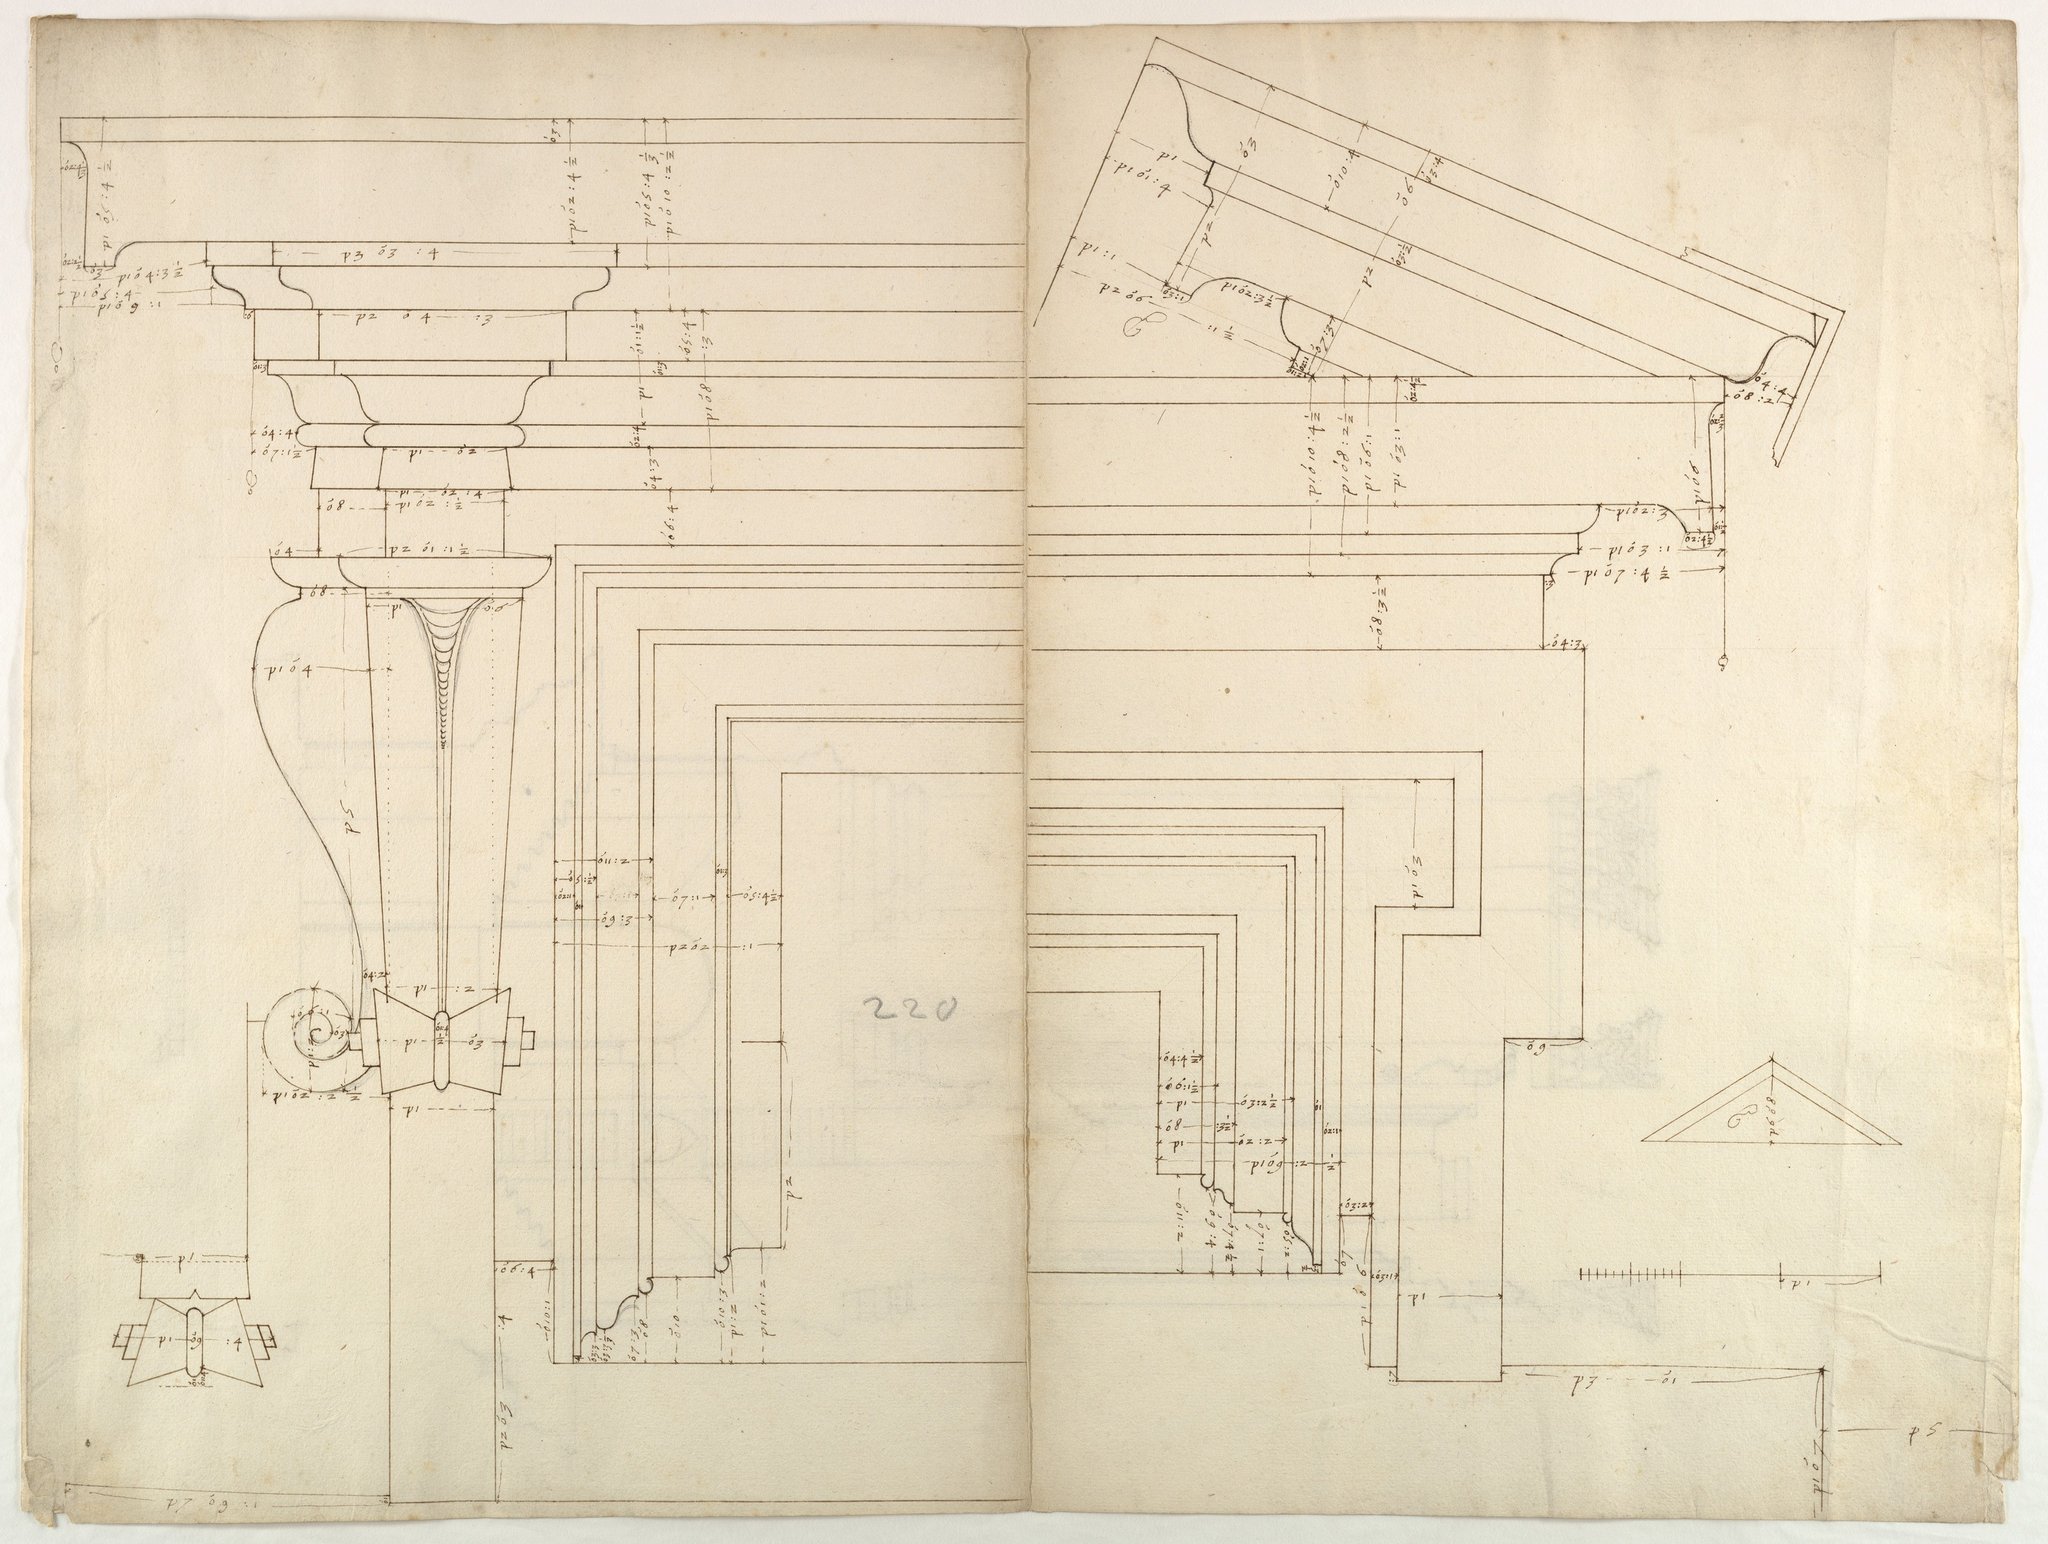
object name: drawing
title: St. Peter's, drum, exterior bay, elevation with details (recto) St. Peter's, drum, section (verso)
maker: anonymous, french, 16th century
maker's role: draftsman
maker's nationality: french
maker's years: 1500-1600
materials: chalk, ink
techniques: incising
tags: architecture